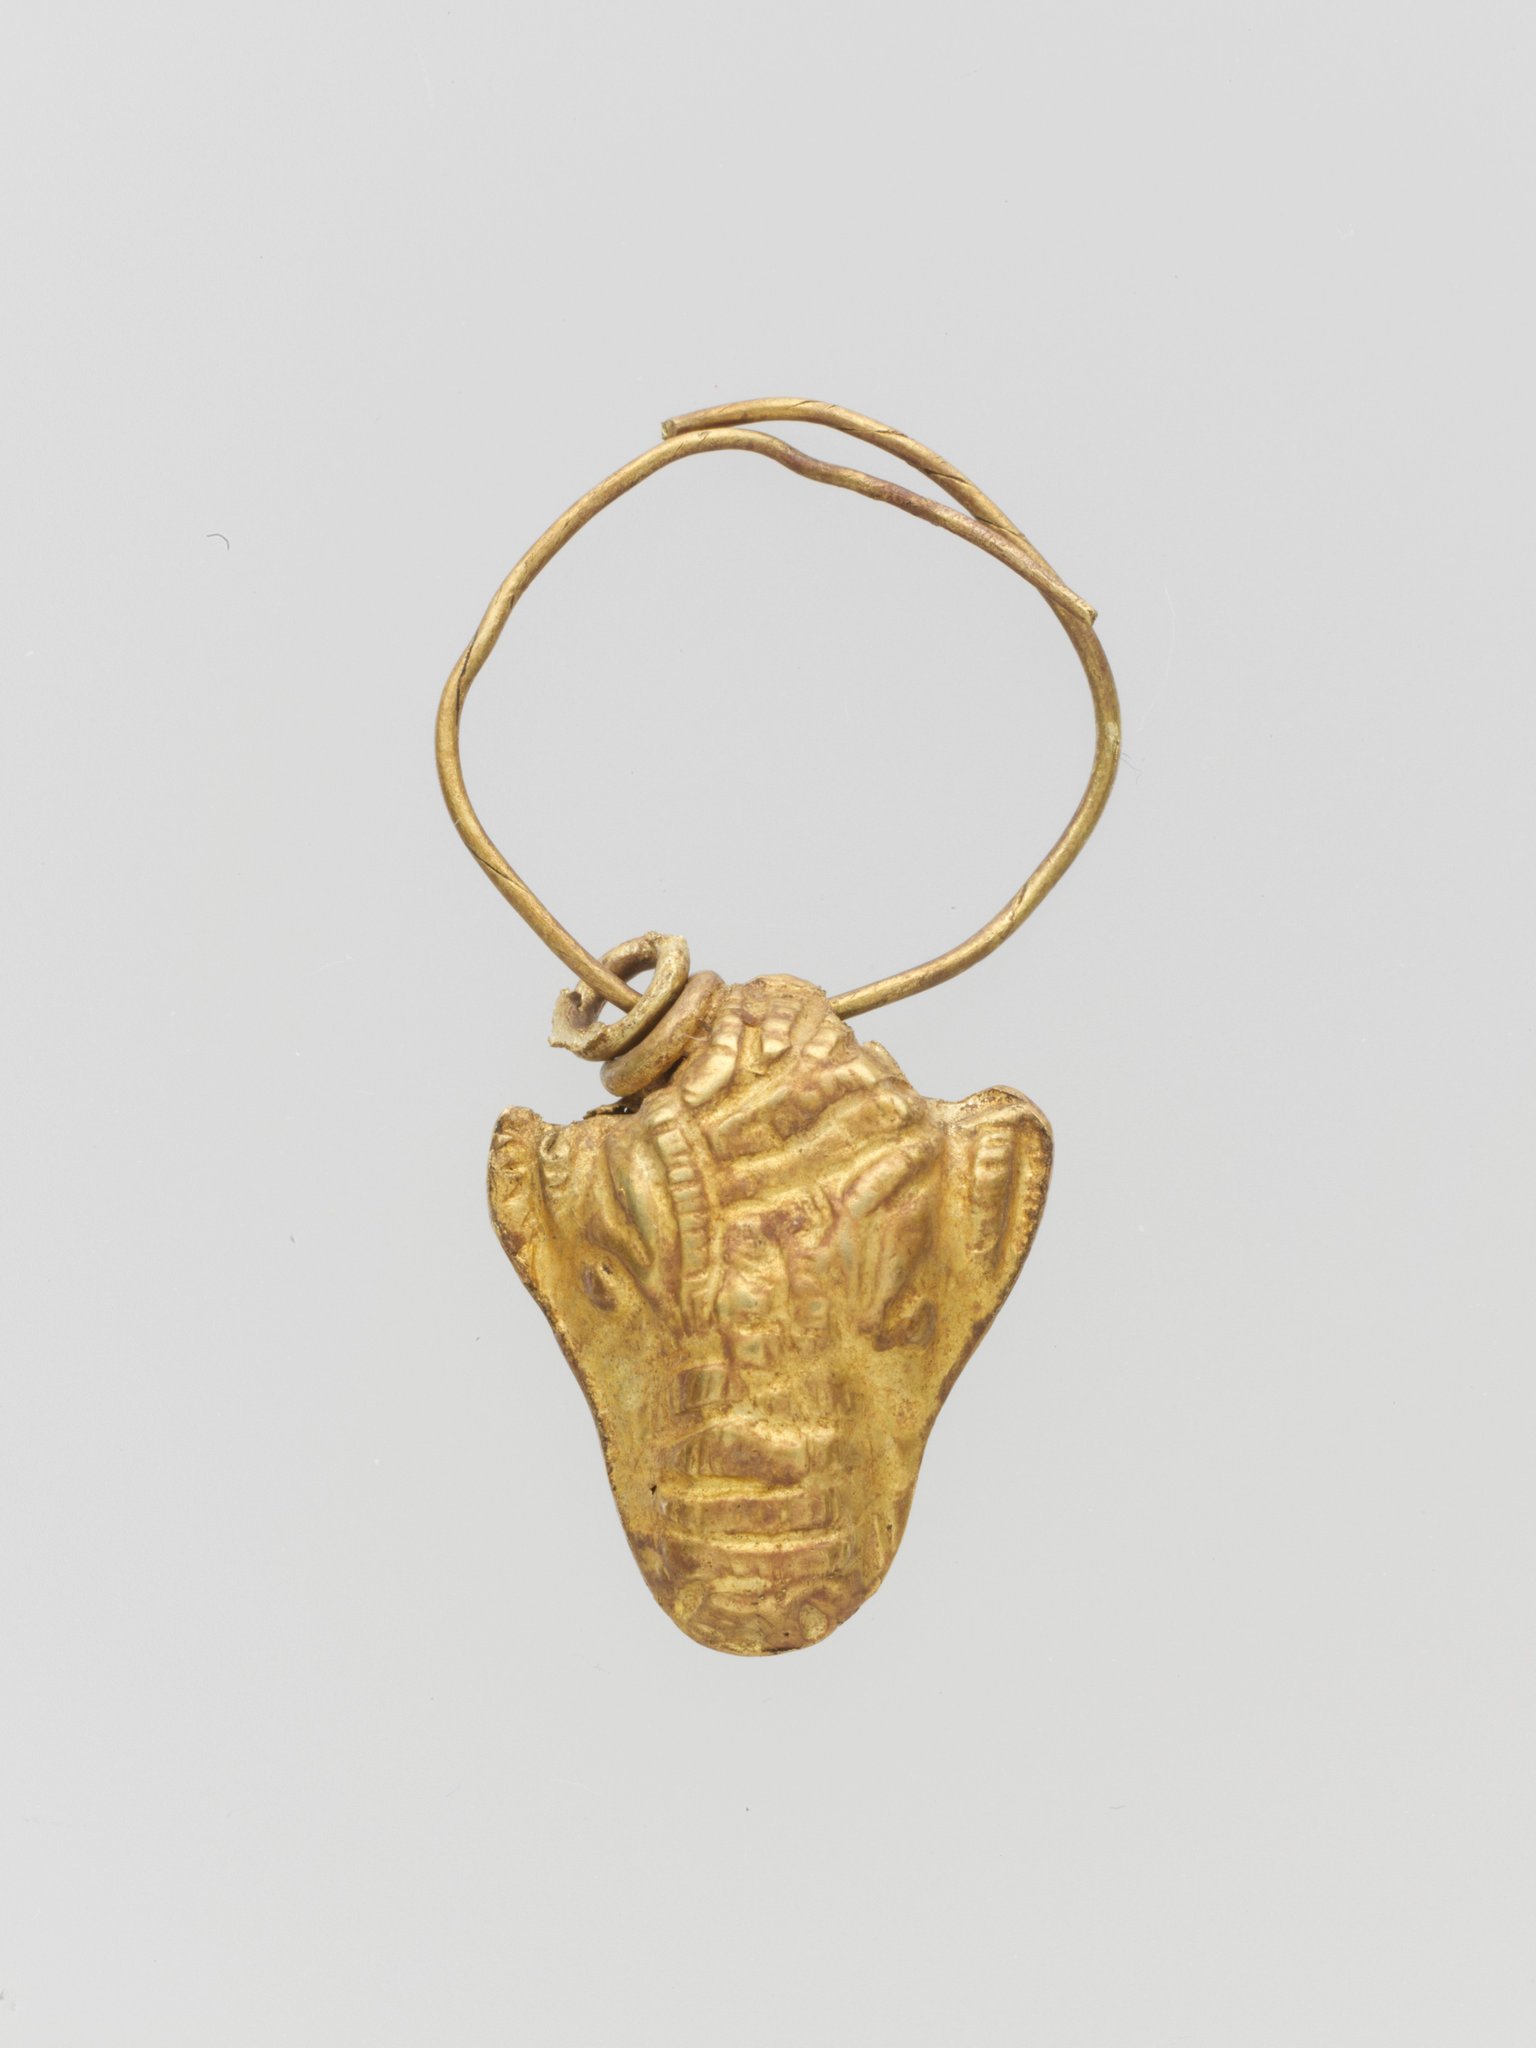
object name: earring with head of bull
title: Gold pendant in the form of a bull's head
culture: cypriot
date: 1400-1050 BCE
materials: gold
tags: bulls